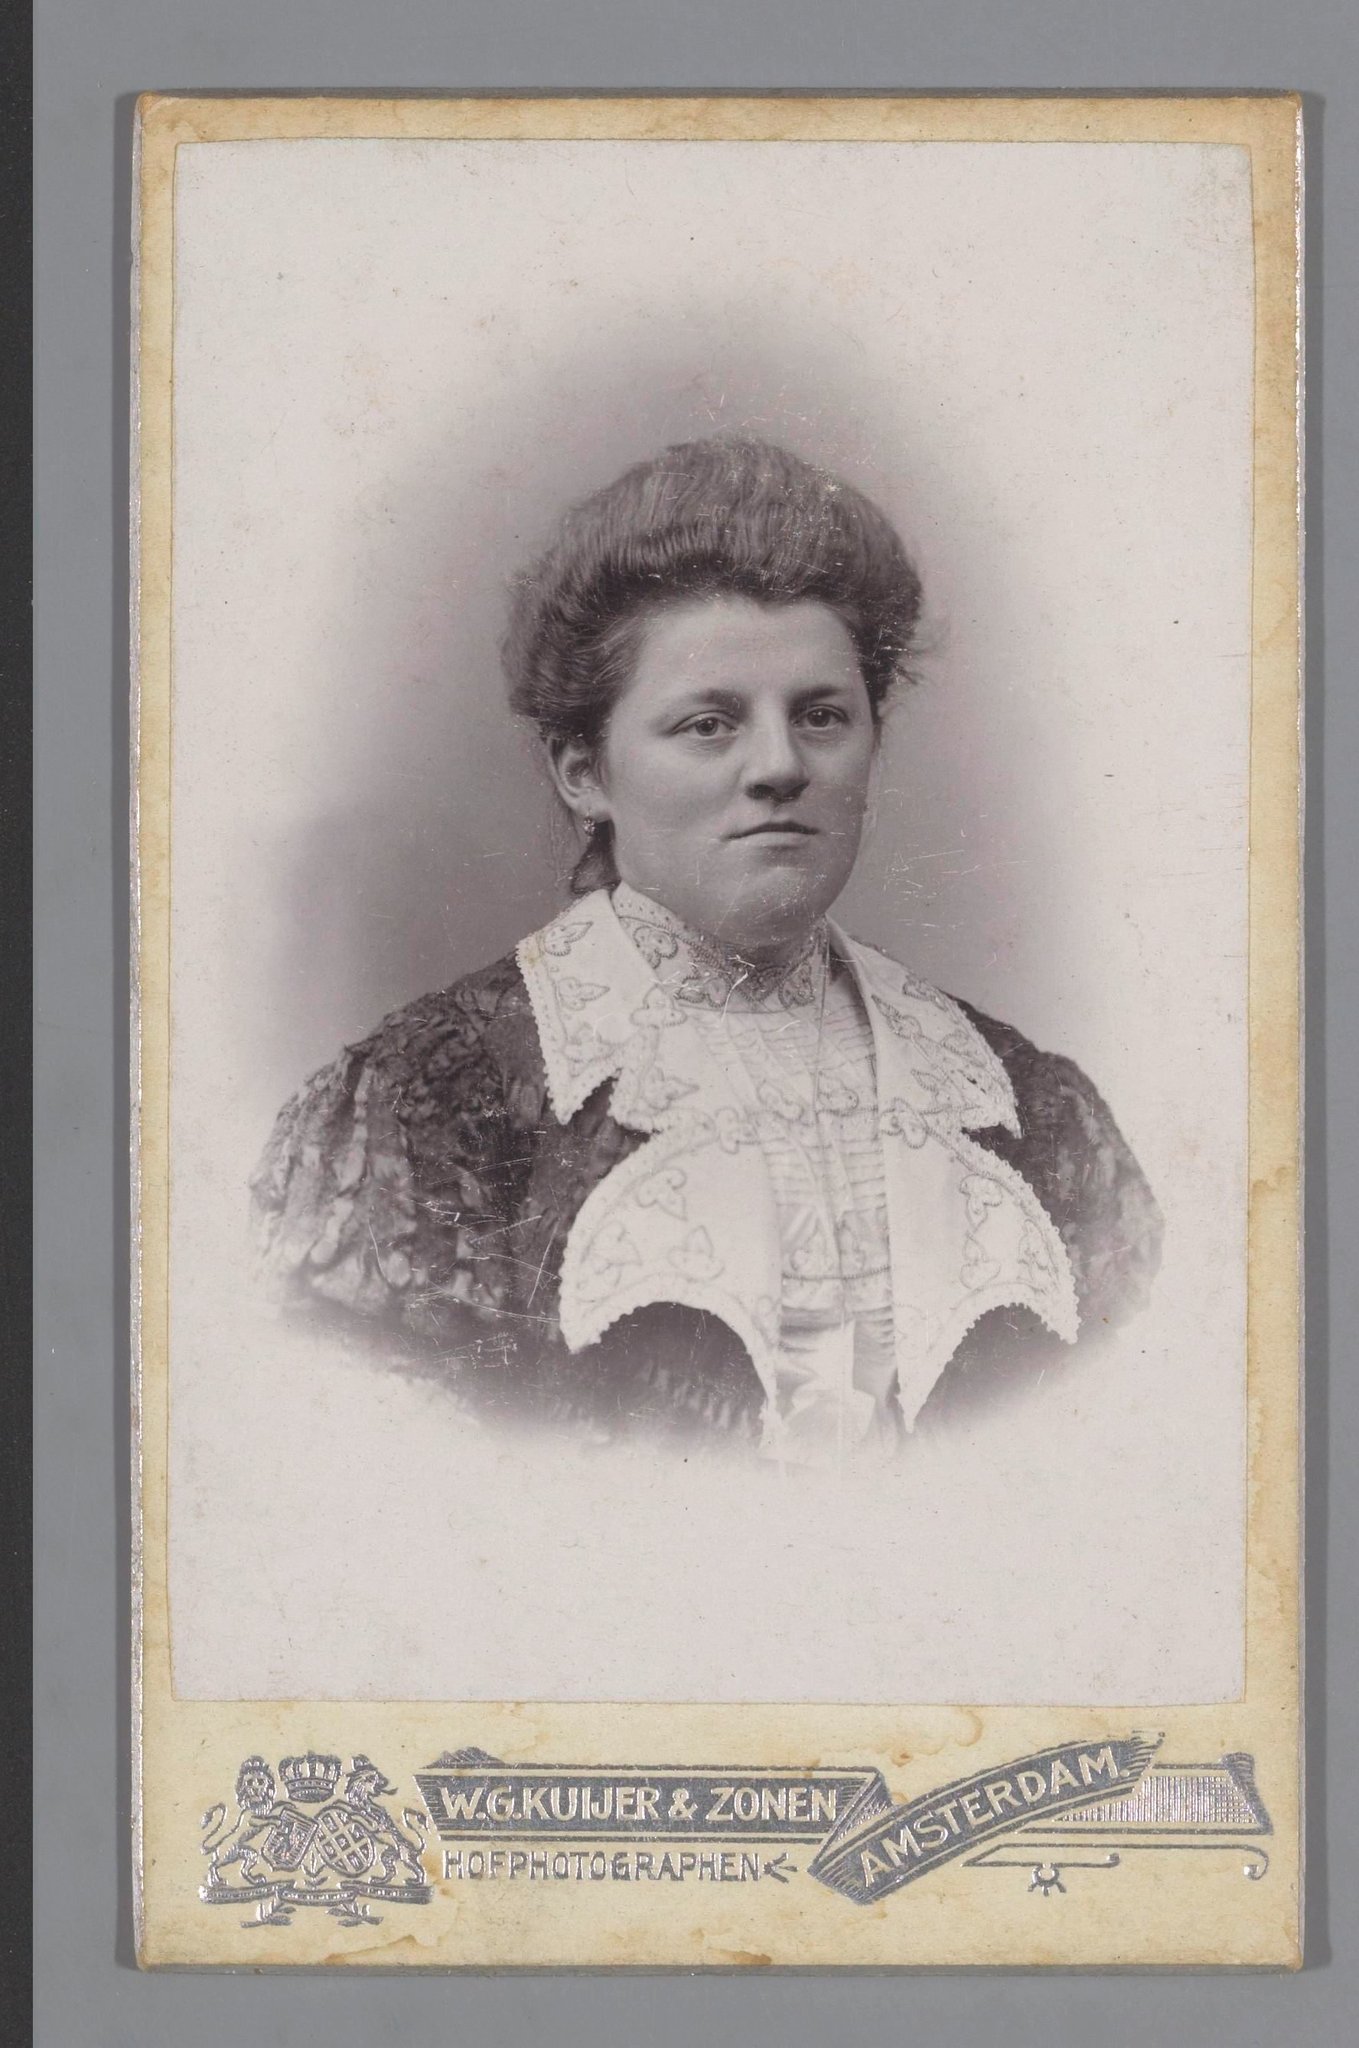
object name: photograph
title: Portret van een onbekende vrouw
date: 1885-1928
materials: cardboard, paper, photographic support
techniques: collodion silver print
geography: amsterdam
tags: adult woman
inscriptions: name: ‘W.G. Kuijer & Zonen Hofphotographen Amsterdam’, inscription: ‘Opgericht 1864 W.G. Kuijer & Zonen Hofphotographen Westermarkt 19 Amsterdam 17 Spéciale Inrichting voor Vergrootingen in alle Formaten.’